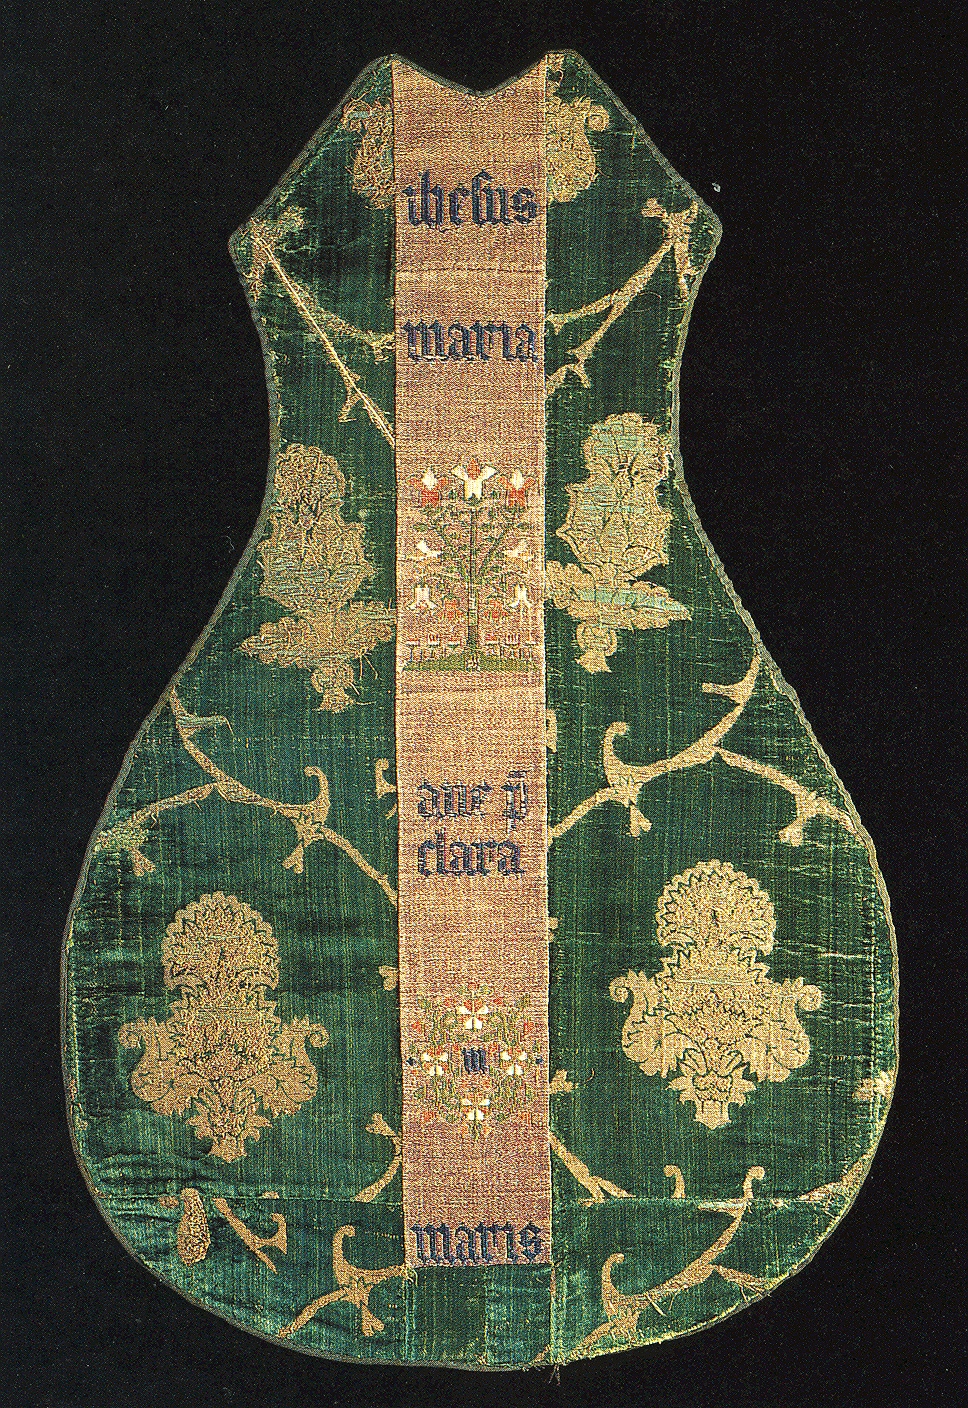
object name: chasuble front with orphrey band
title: Chasuble Front with an Orphrey Band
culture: italian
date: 1401-1500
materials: animal substrate, cotton, gilt, linen, metal, metal thread, silk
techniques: bookbinding, brocade, glazing, lining, weave